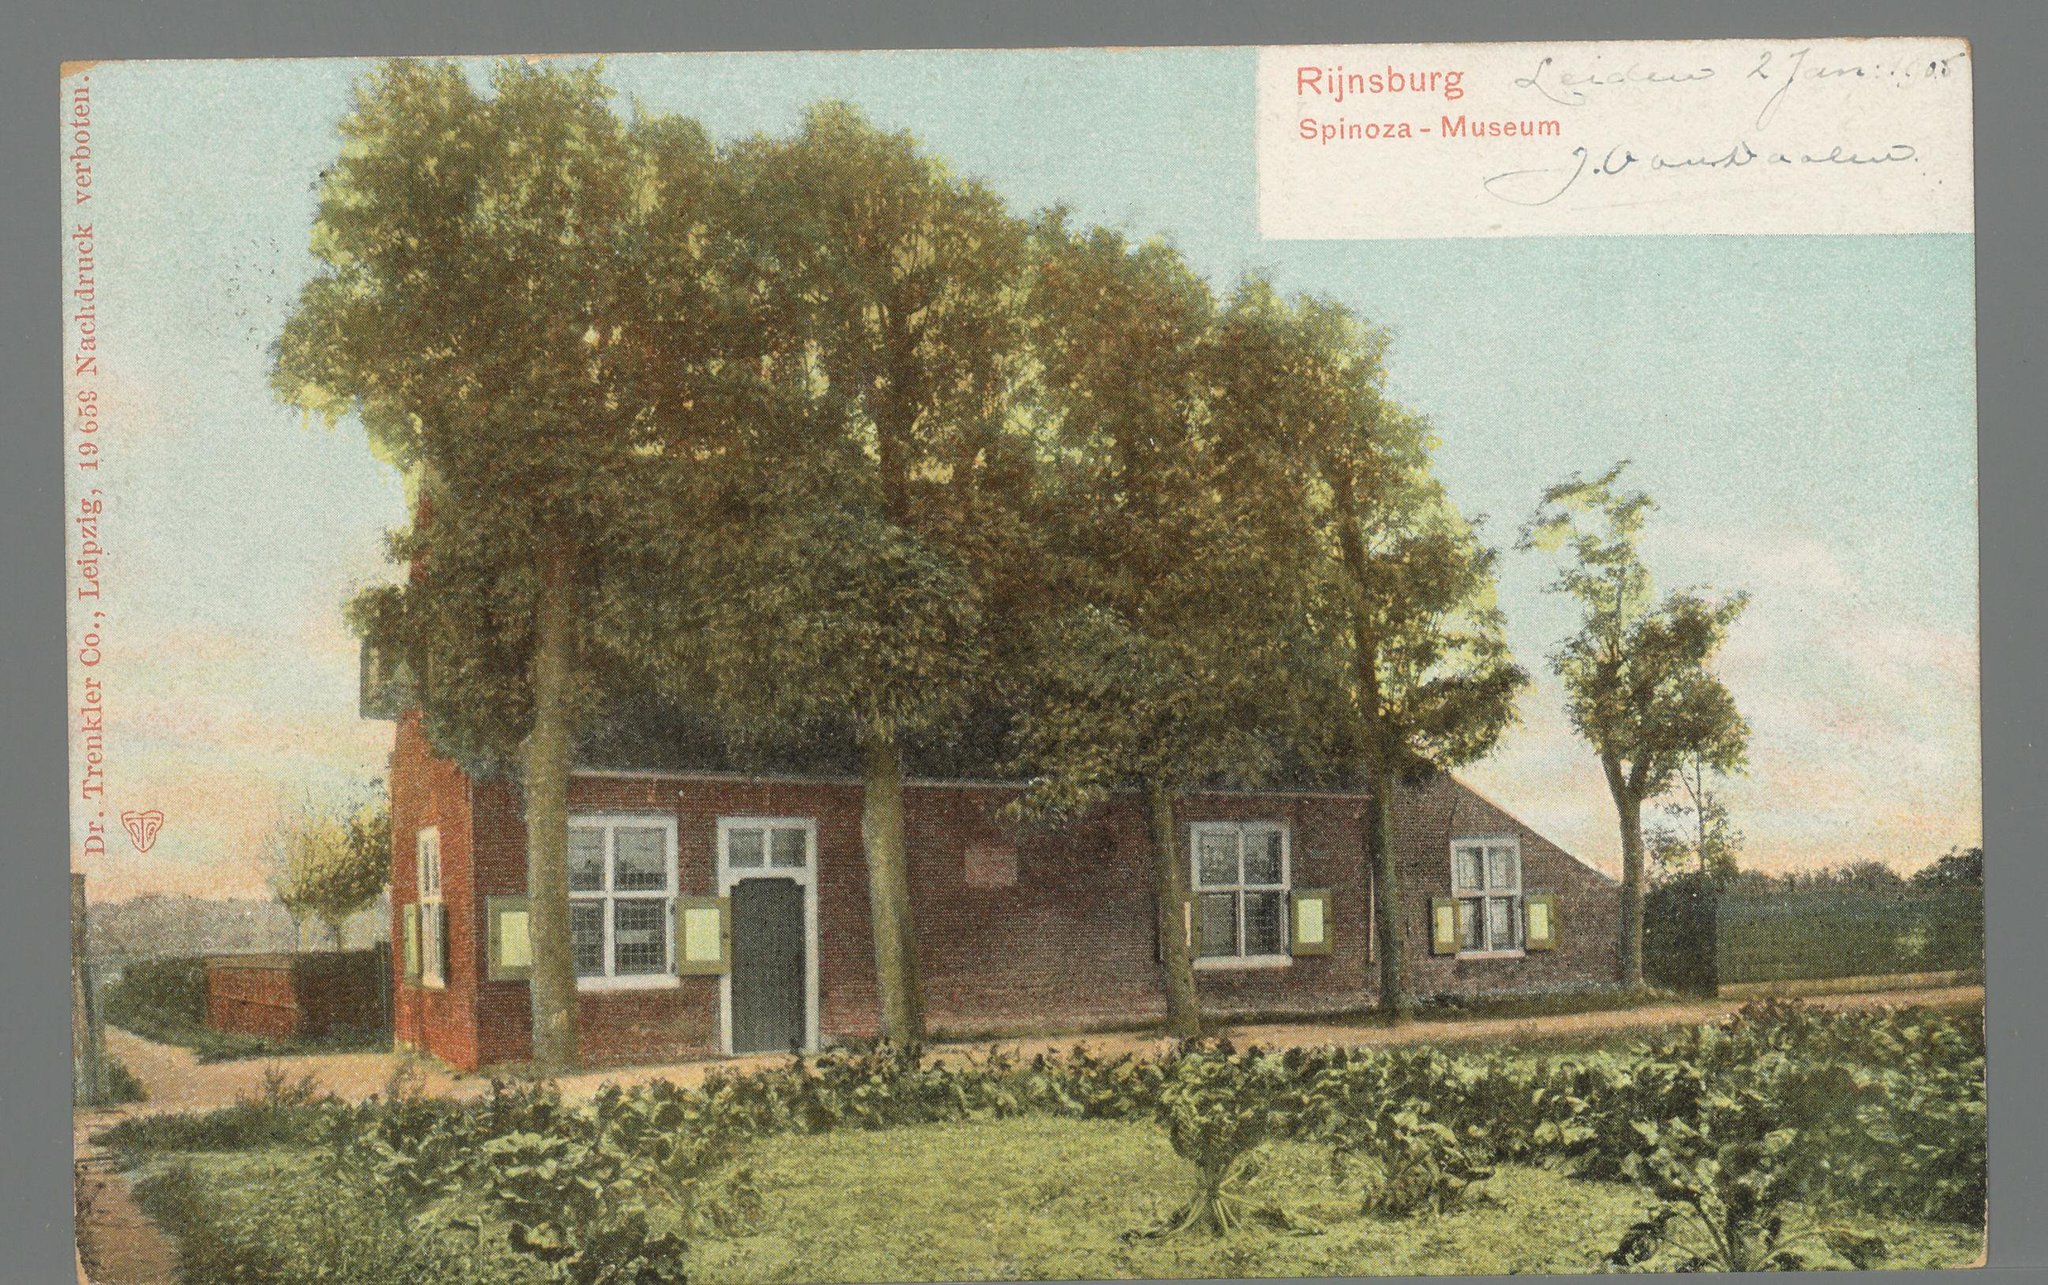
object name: ansichtkaart, prentbriefkaart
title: Rijnsburg. Spinoza-museum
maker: Anonymous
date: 1894-1905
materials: cardboard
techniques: lithograph, writing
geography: rijnsburg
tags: permanent exhibition, museum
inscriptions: postage stamp